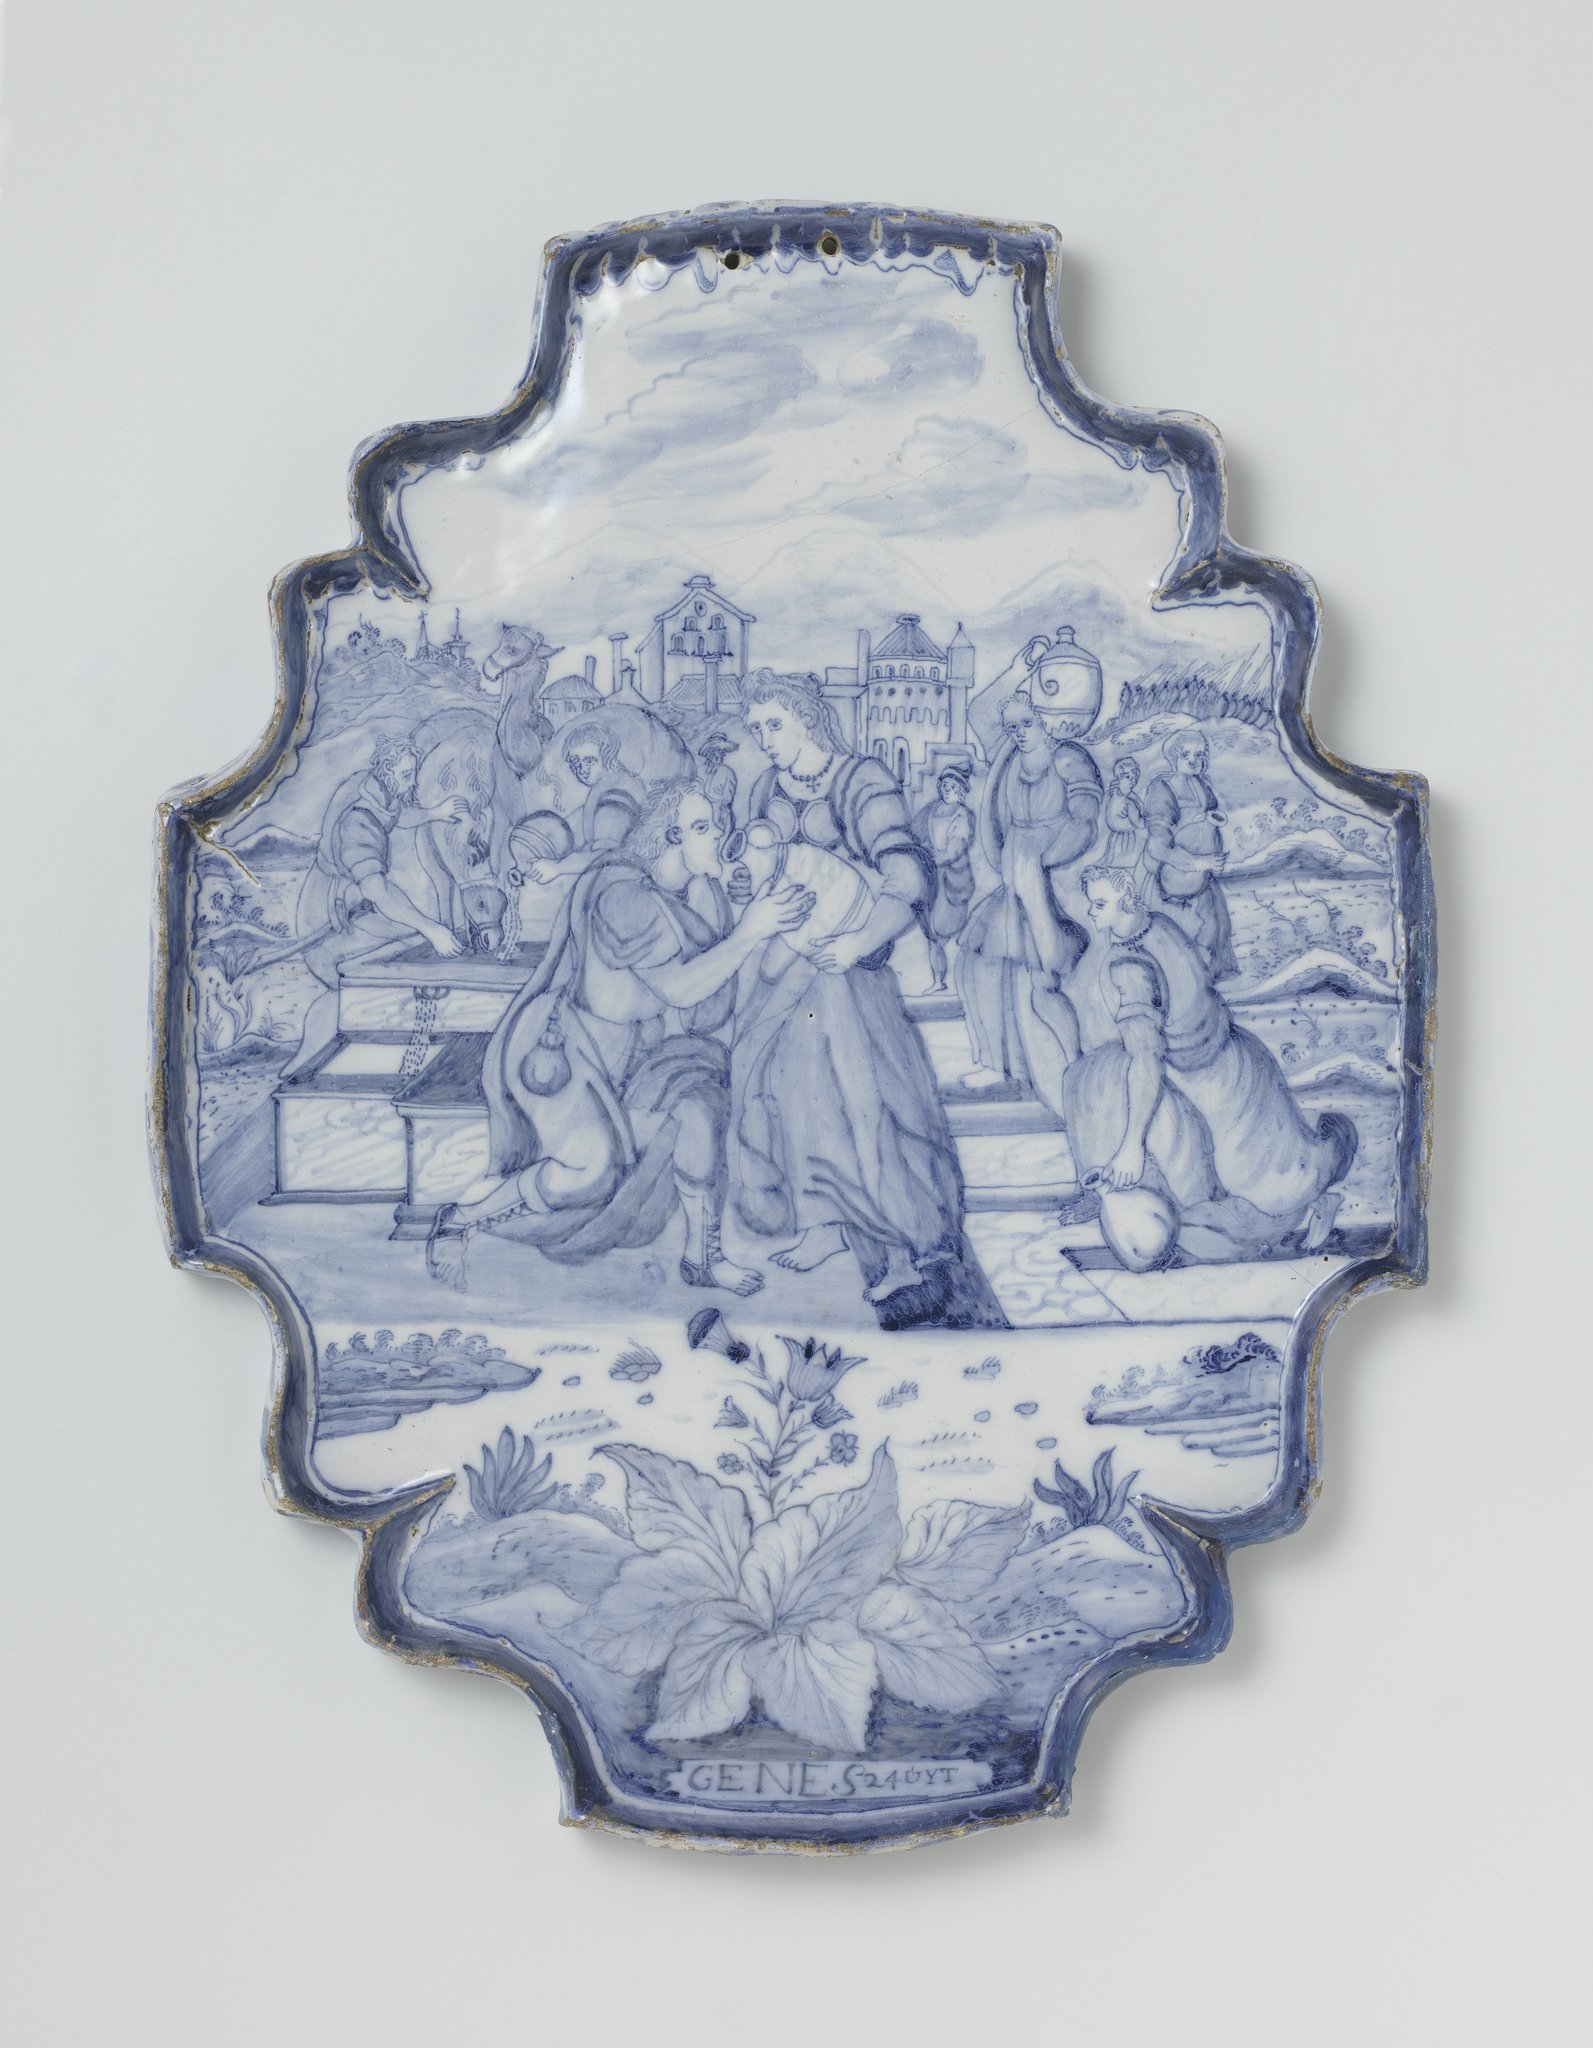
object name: plaque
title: Plaat met voorstelling van Eliezer en Rebecca, Genesis 24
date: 1740-1780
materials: faience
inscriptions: inscription: ‘GENES 24 UYT’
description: Plaat van faïence. Met de voorstelling van Eliezer en Rebecca, Genesis 24.